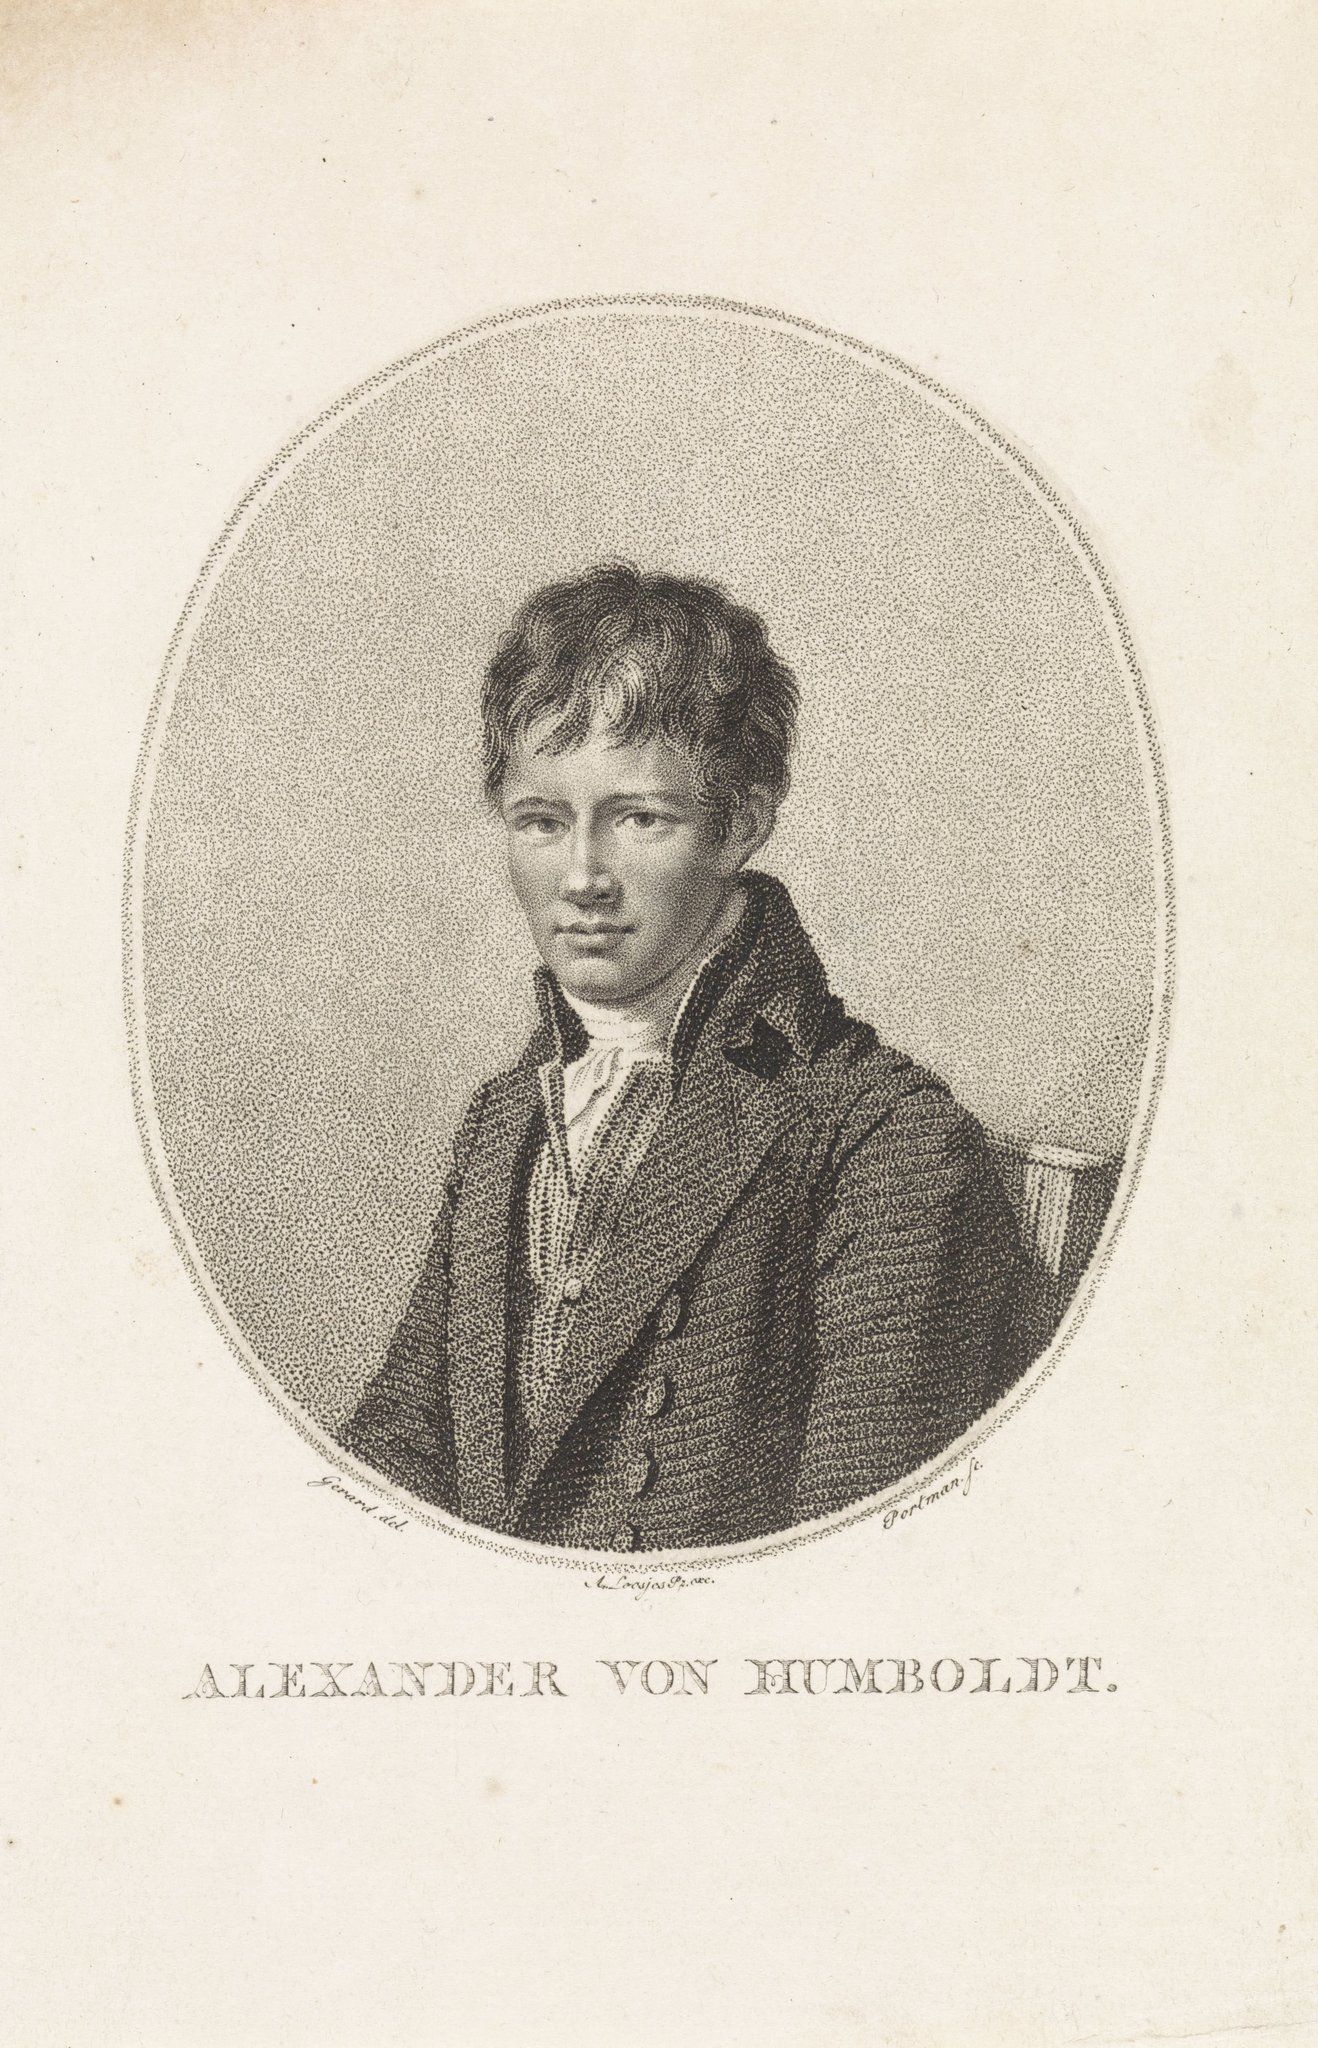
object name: print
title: Portret van de Duitse wetenschapper Alexander von Humboldt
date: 1787-1828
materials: paper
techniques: stippled etching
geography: haarlem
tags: berlin, traveler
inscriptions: collector's mark: Lugt 2233